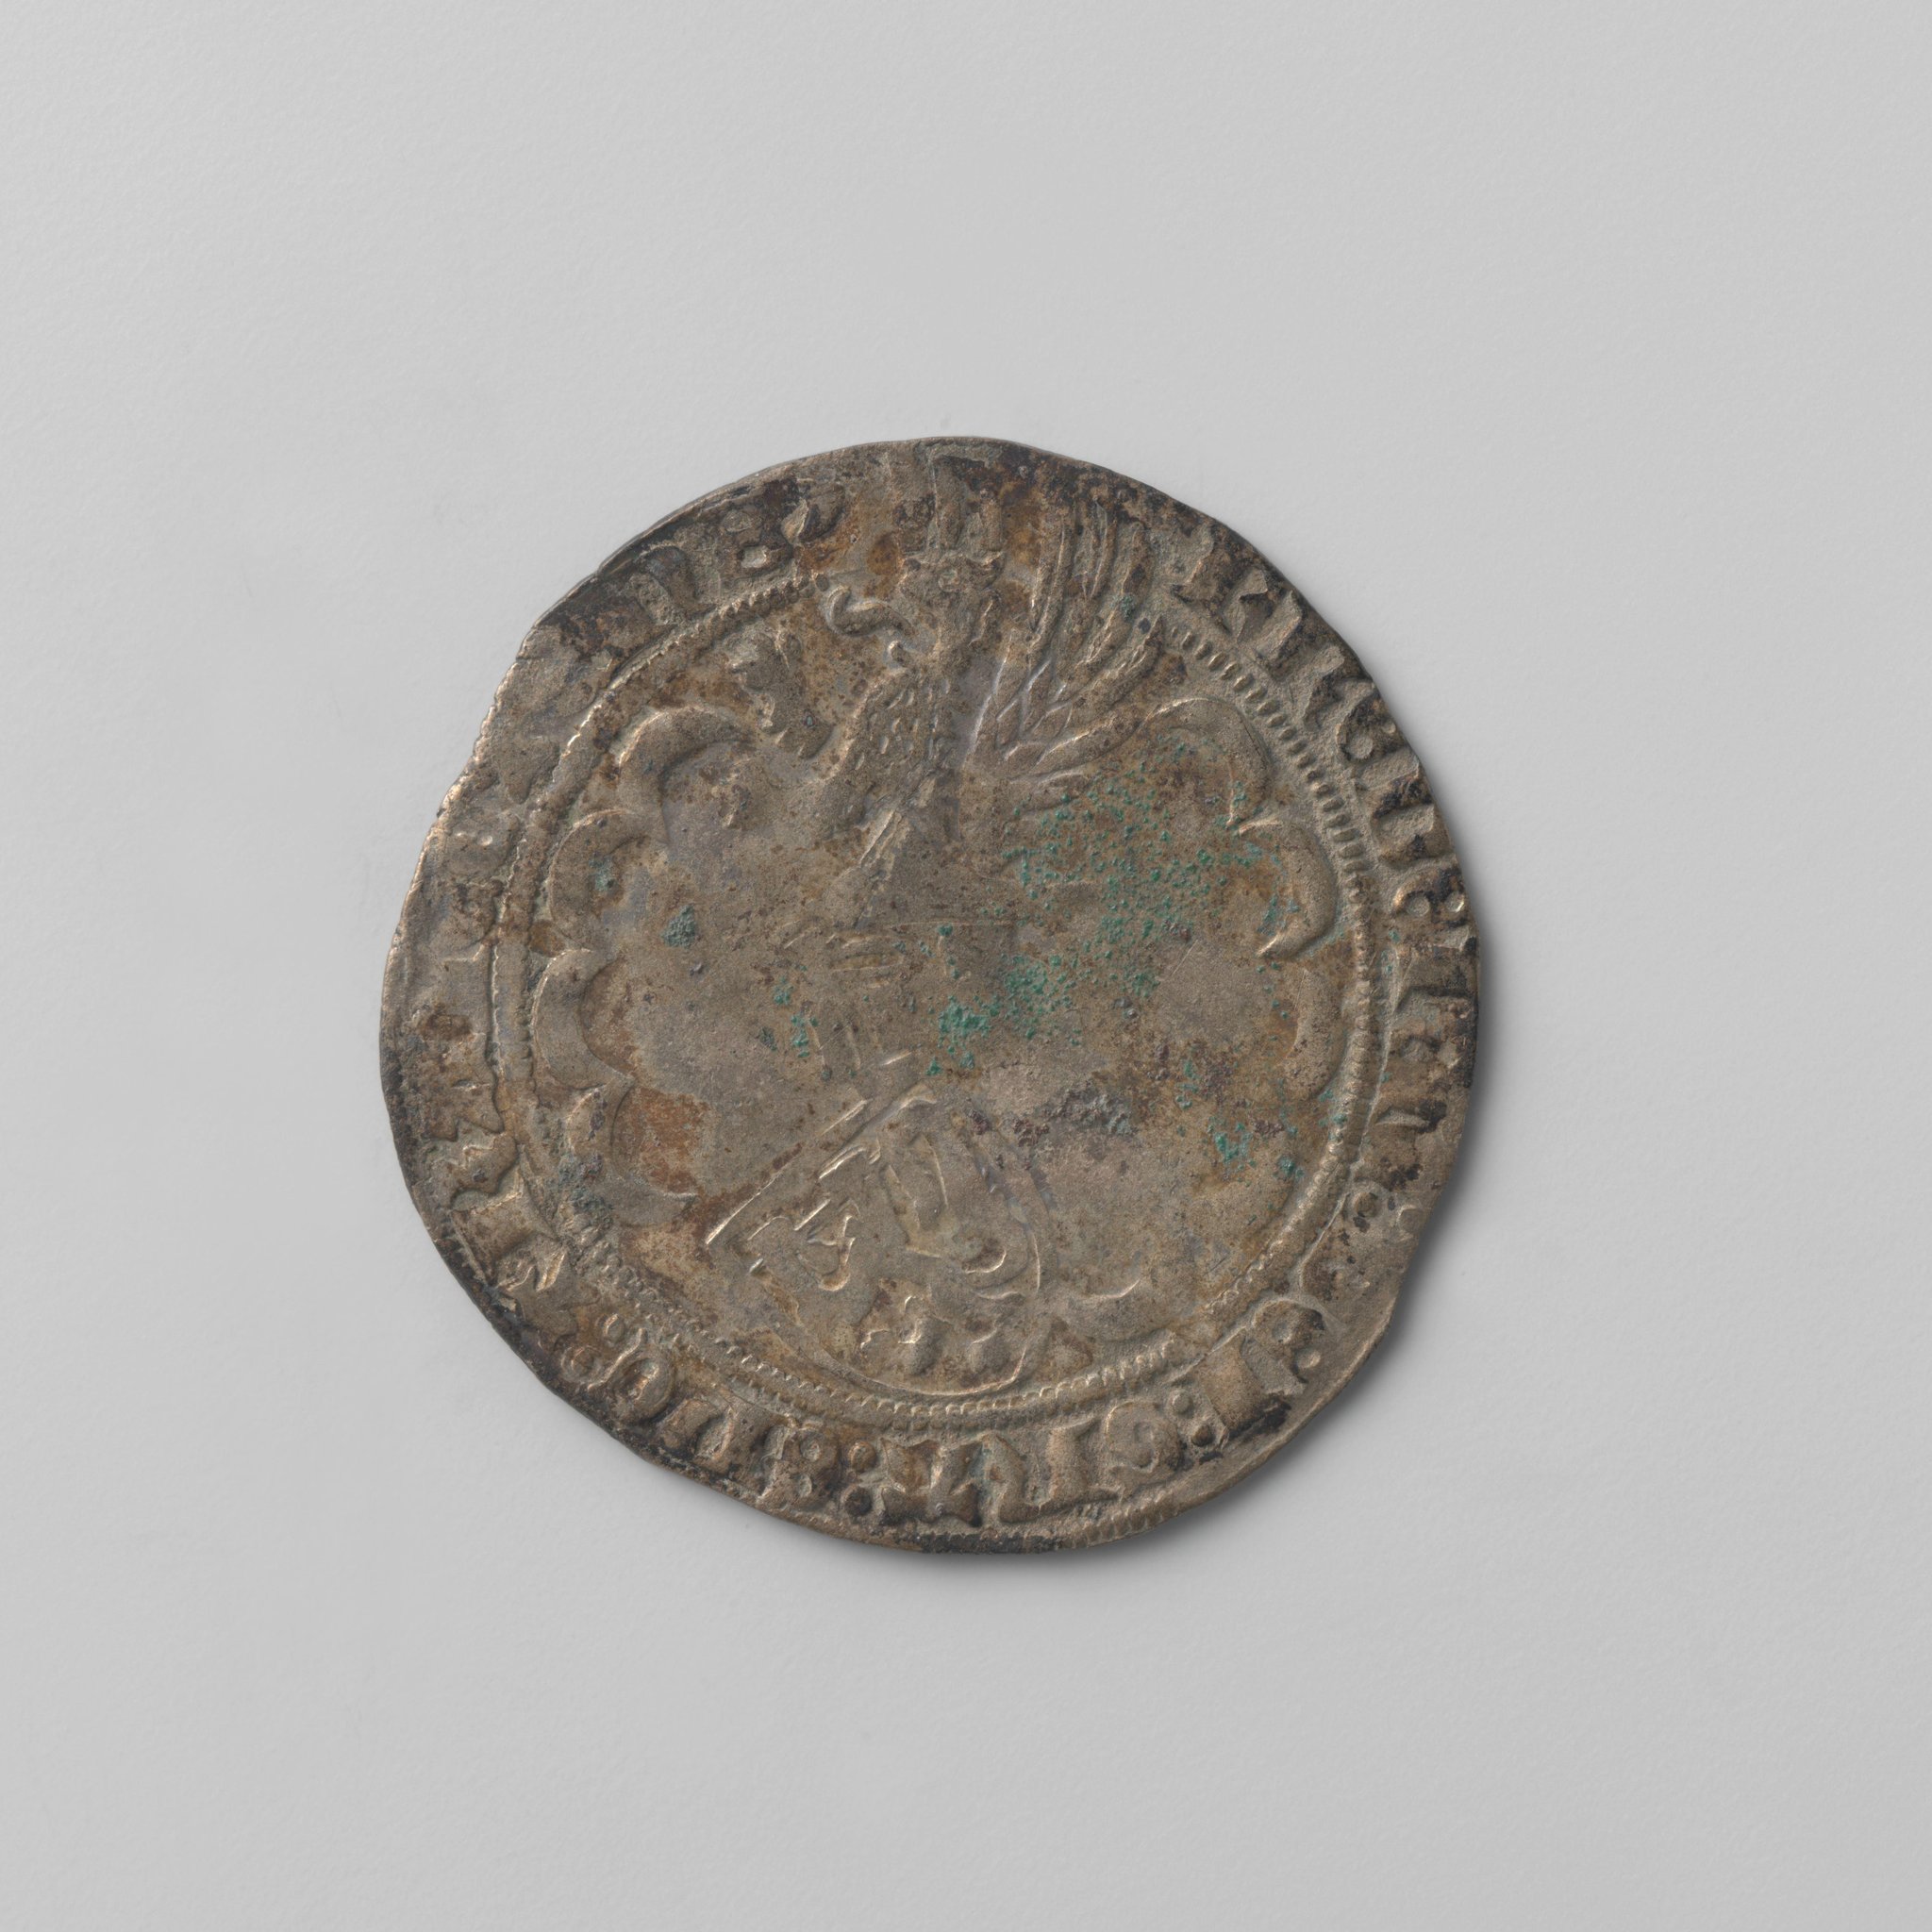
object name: coin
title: Utrechtse dubbele plak van Frederik van Blankenheim, 1393-1423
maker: frederik van blankenheim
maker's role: bisschop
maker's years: 1355-1423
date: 1393-1423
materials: silver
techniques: striking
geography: hasselt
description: Zilveren munt. Voorzijde: binnen veelpas gehelmd schuin geplaatst wapenschild van Blankenheim. Keerzijde: adelaar met op zijn borst wapenschildje van Hasselt (Nederland) en onder zijn poten wapenschild van Utrecht. Dubbel omschrift.